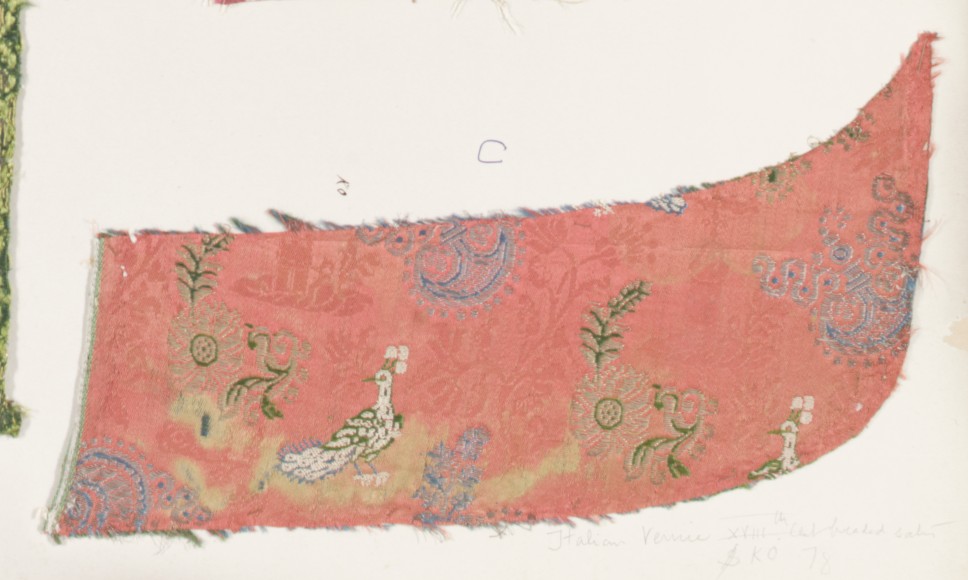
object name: fragment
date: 1701-1750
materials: metal thread, silk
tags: peacocks,flowers